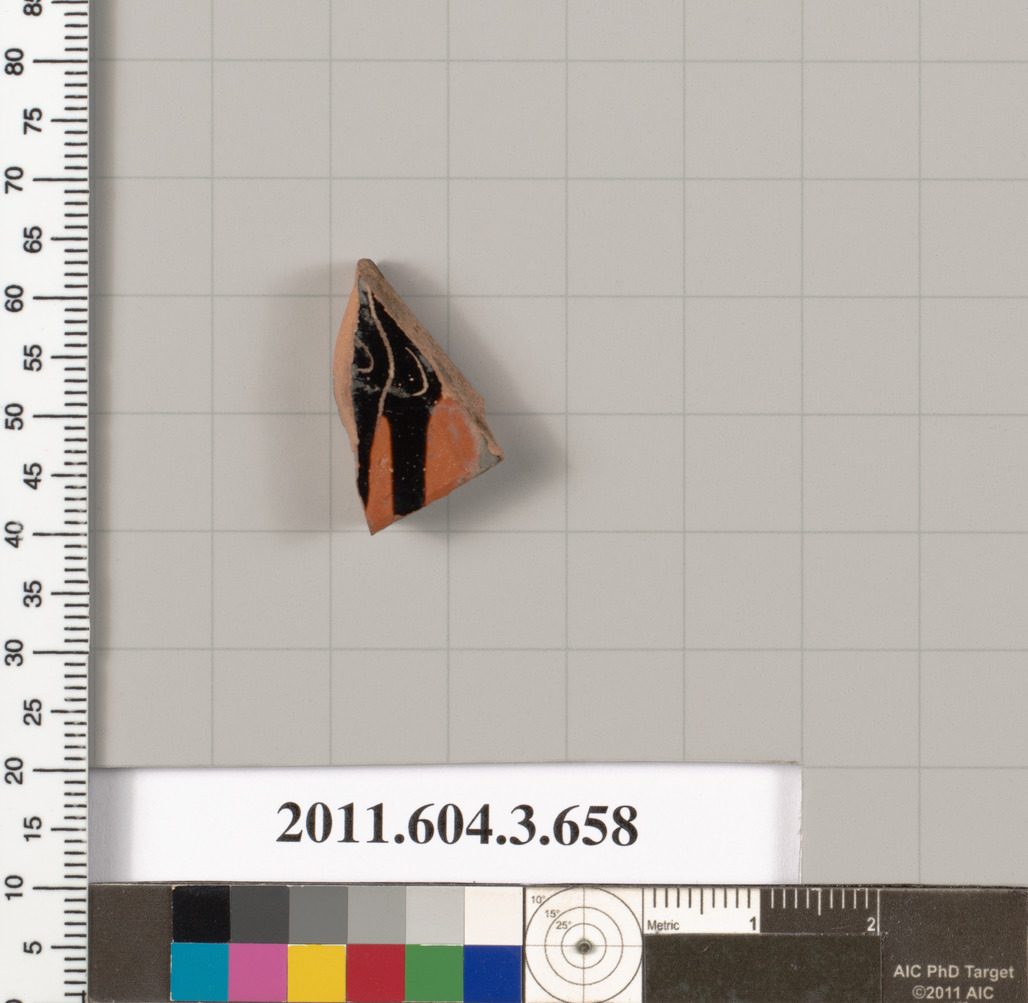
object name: volute krater fragment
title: Terracotta fragment of a volute-krater (bowl for mixing wine and water)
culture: greek, attic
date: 520-510 BCE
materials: terracotta